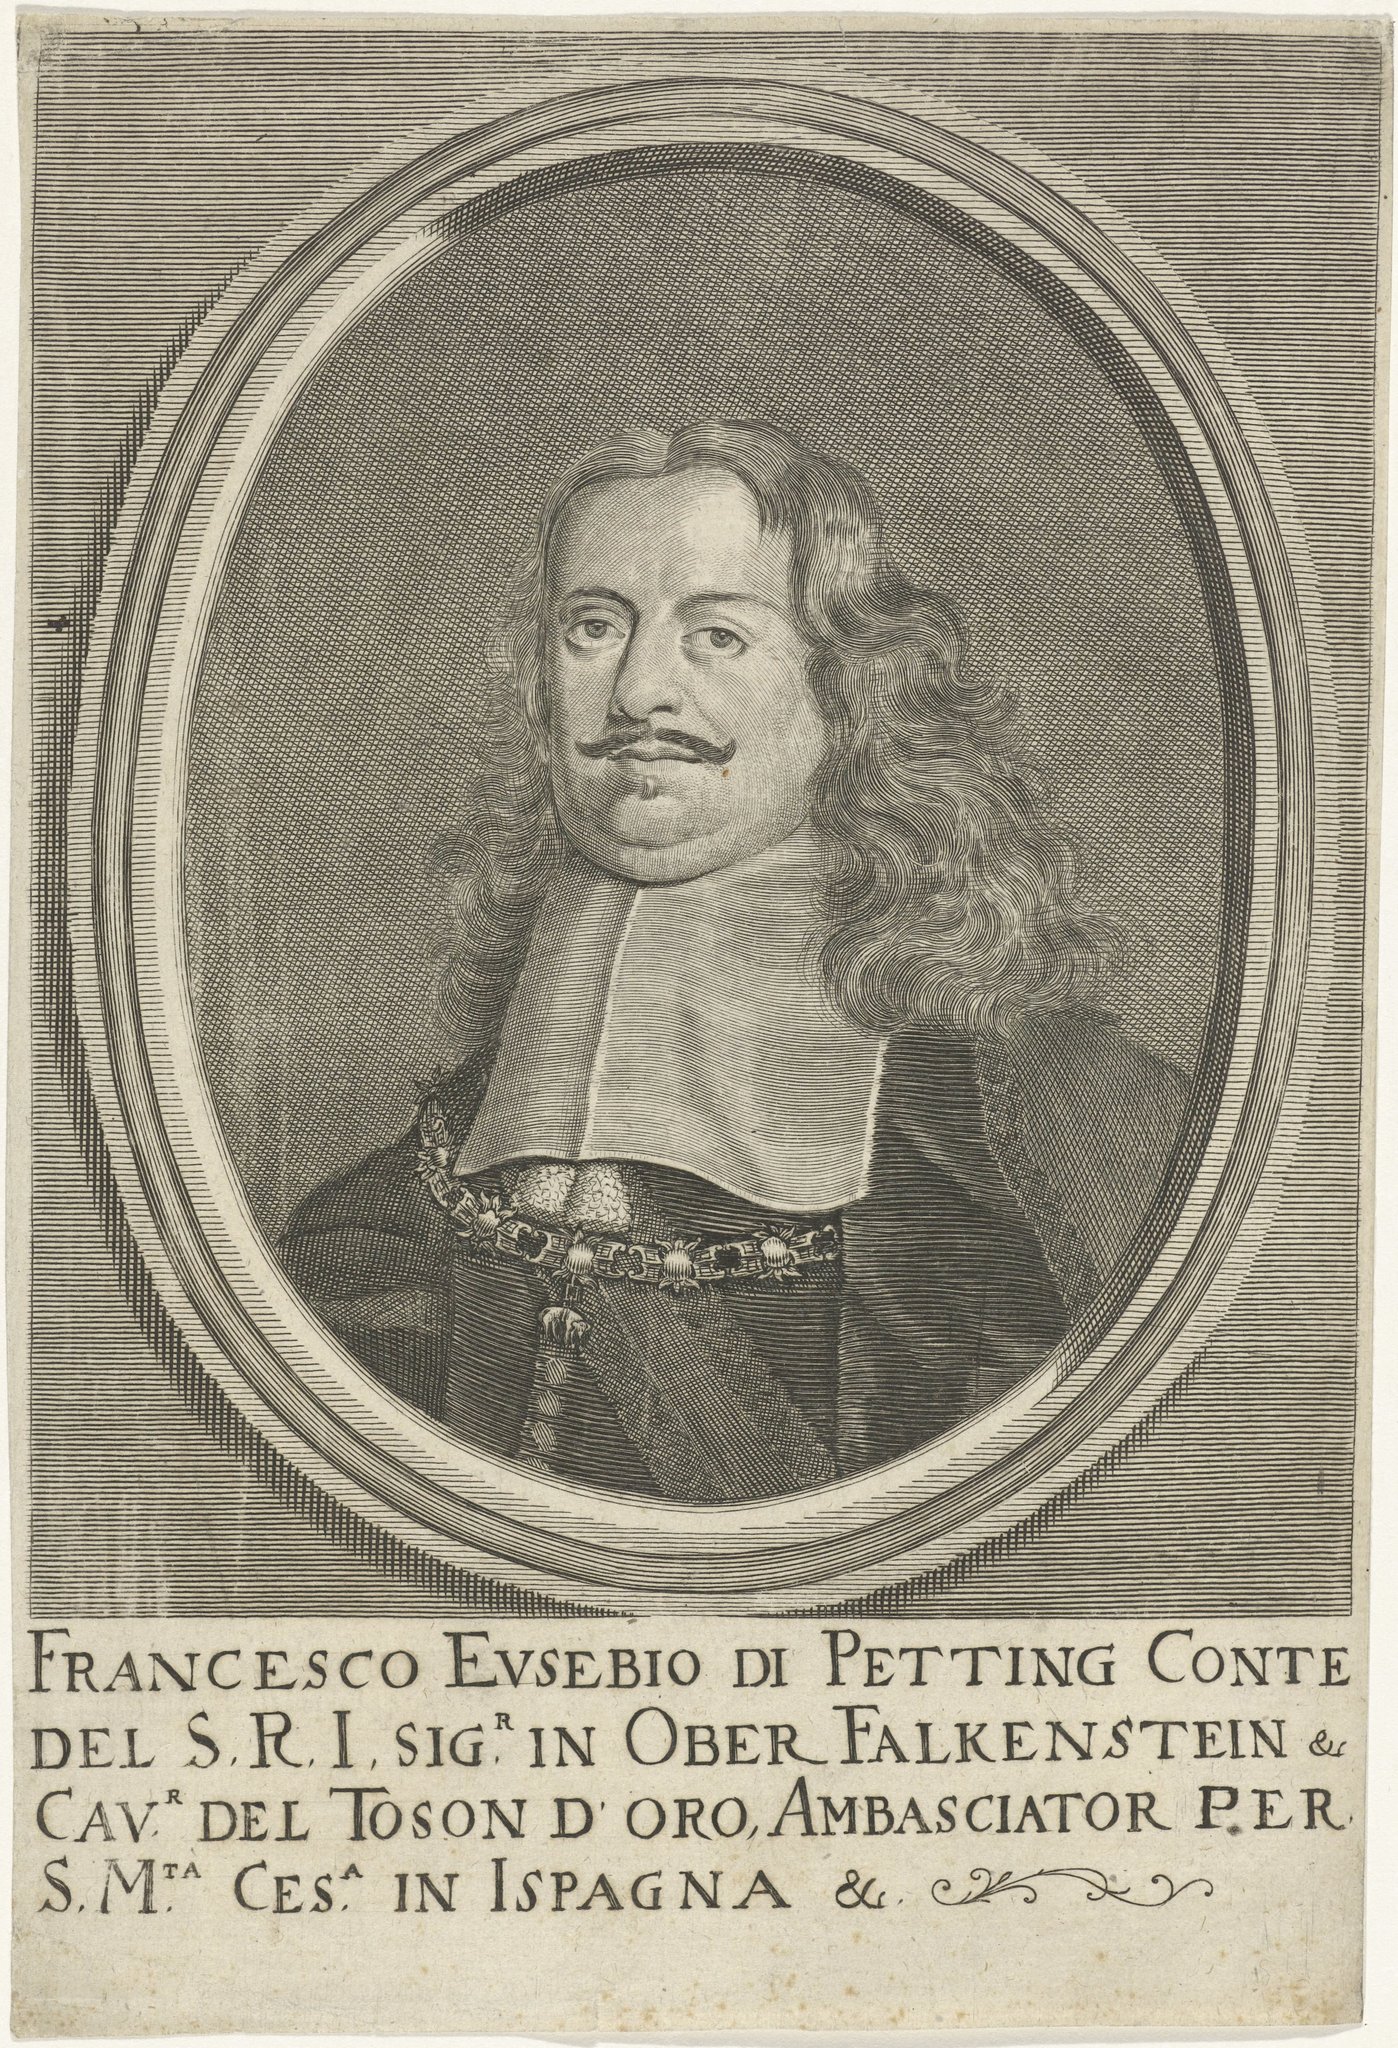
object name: print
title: Portret van Francesco Eusebio van Pettingen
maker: johann friedrich leonard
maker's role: print maker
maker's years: 1633-1680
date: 1643-1680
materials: paper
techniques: engraving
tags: knighthood order of the golden fleece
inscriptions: collector's mark: Lugt 2233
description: Portret van Francesco Eusebio van Pettingen, keizerlijke ambassadeur te Spanje. Om zijn nek het symbool van de Orde van het Gulden Vlies.